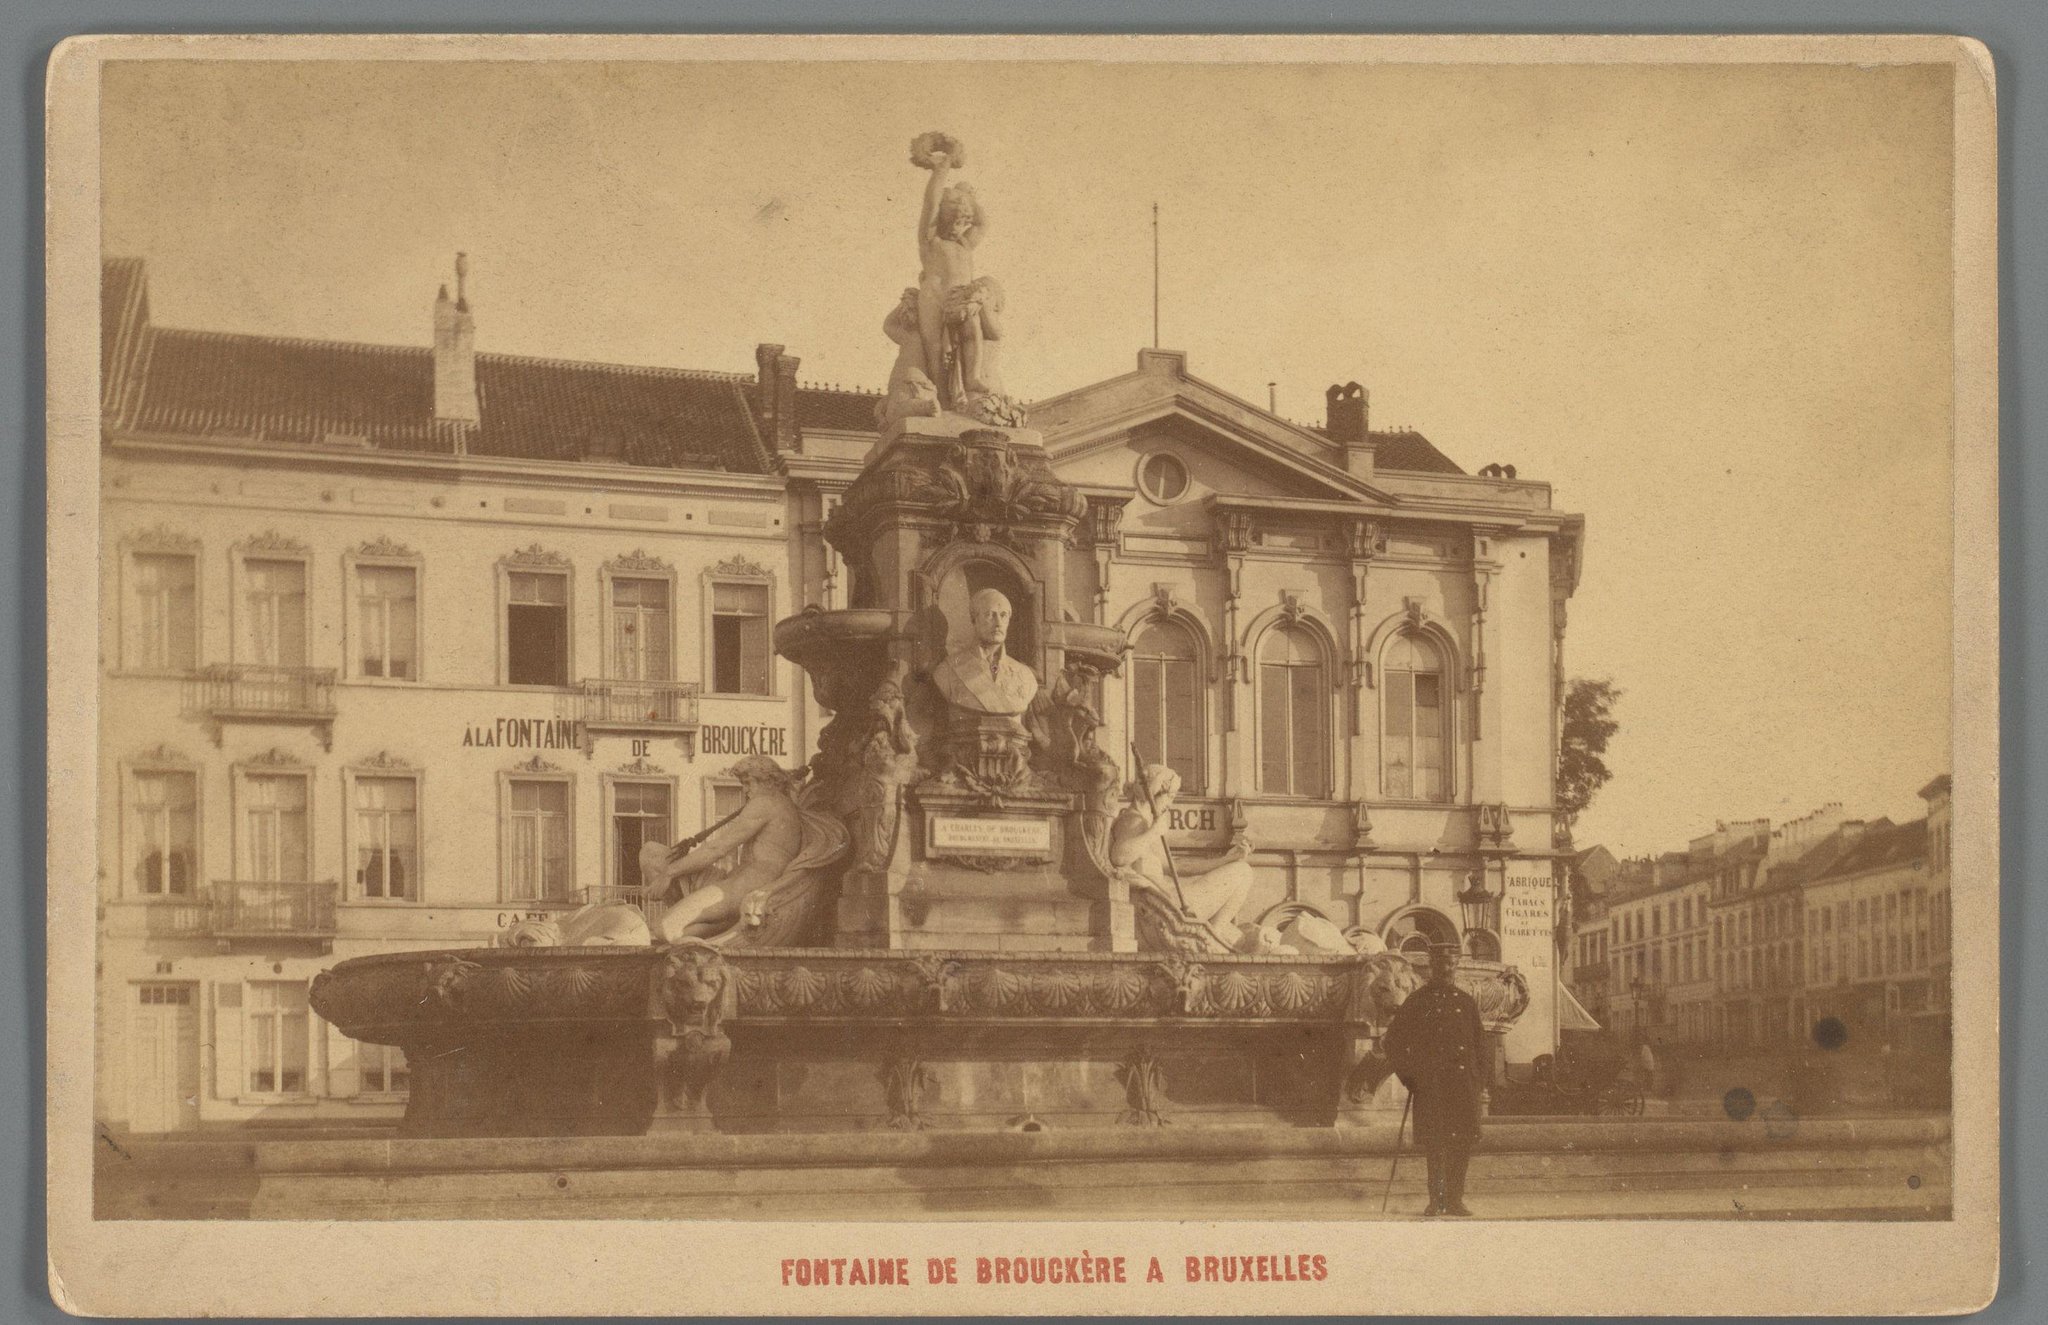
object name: cabinet photograph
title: Fontaine de Brouckère a Bruxelles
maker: alexandre bernheim (jeune)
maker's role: fotograaf, galeriehouder, kunsthandelaar, opticien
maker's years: 1839-1915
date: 1870-1878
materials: cardboard, paper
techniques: albumen print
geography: brussels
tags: ornamental fountain, brussels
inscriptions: inscription: ‘Bernheim Jeune/ 84, Montaigne de la Cour, 84/ Bruxelles/ Tableaux Modernes - Cabinet d'Antiquités’, number: ‘3090’